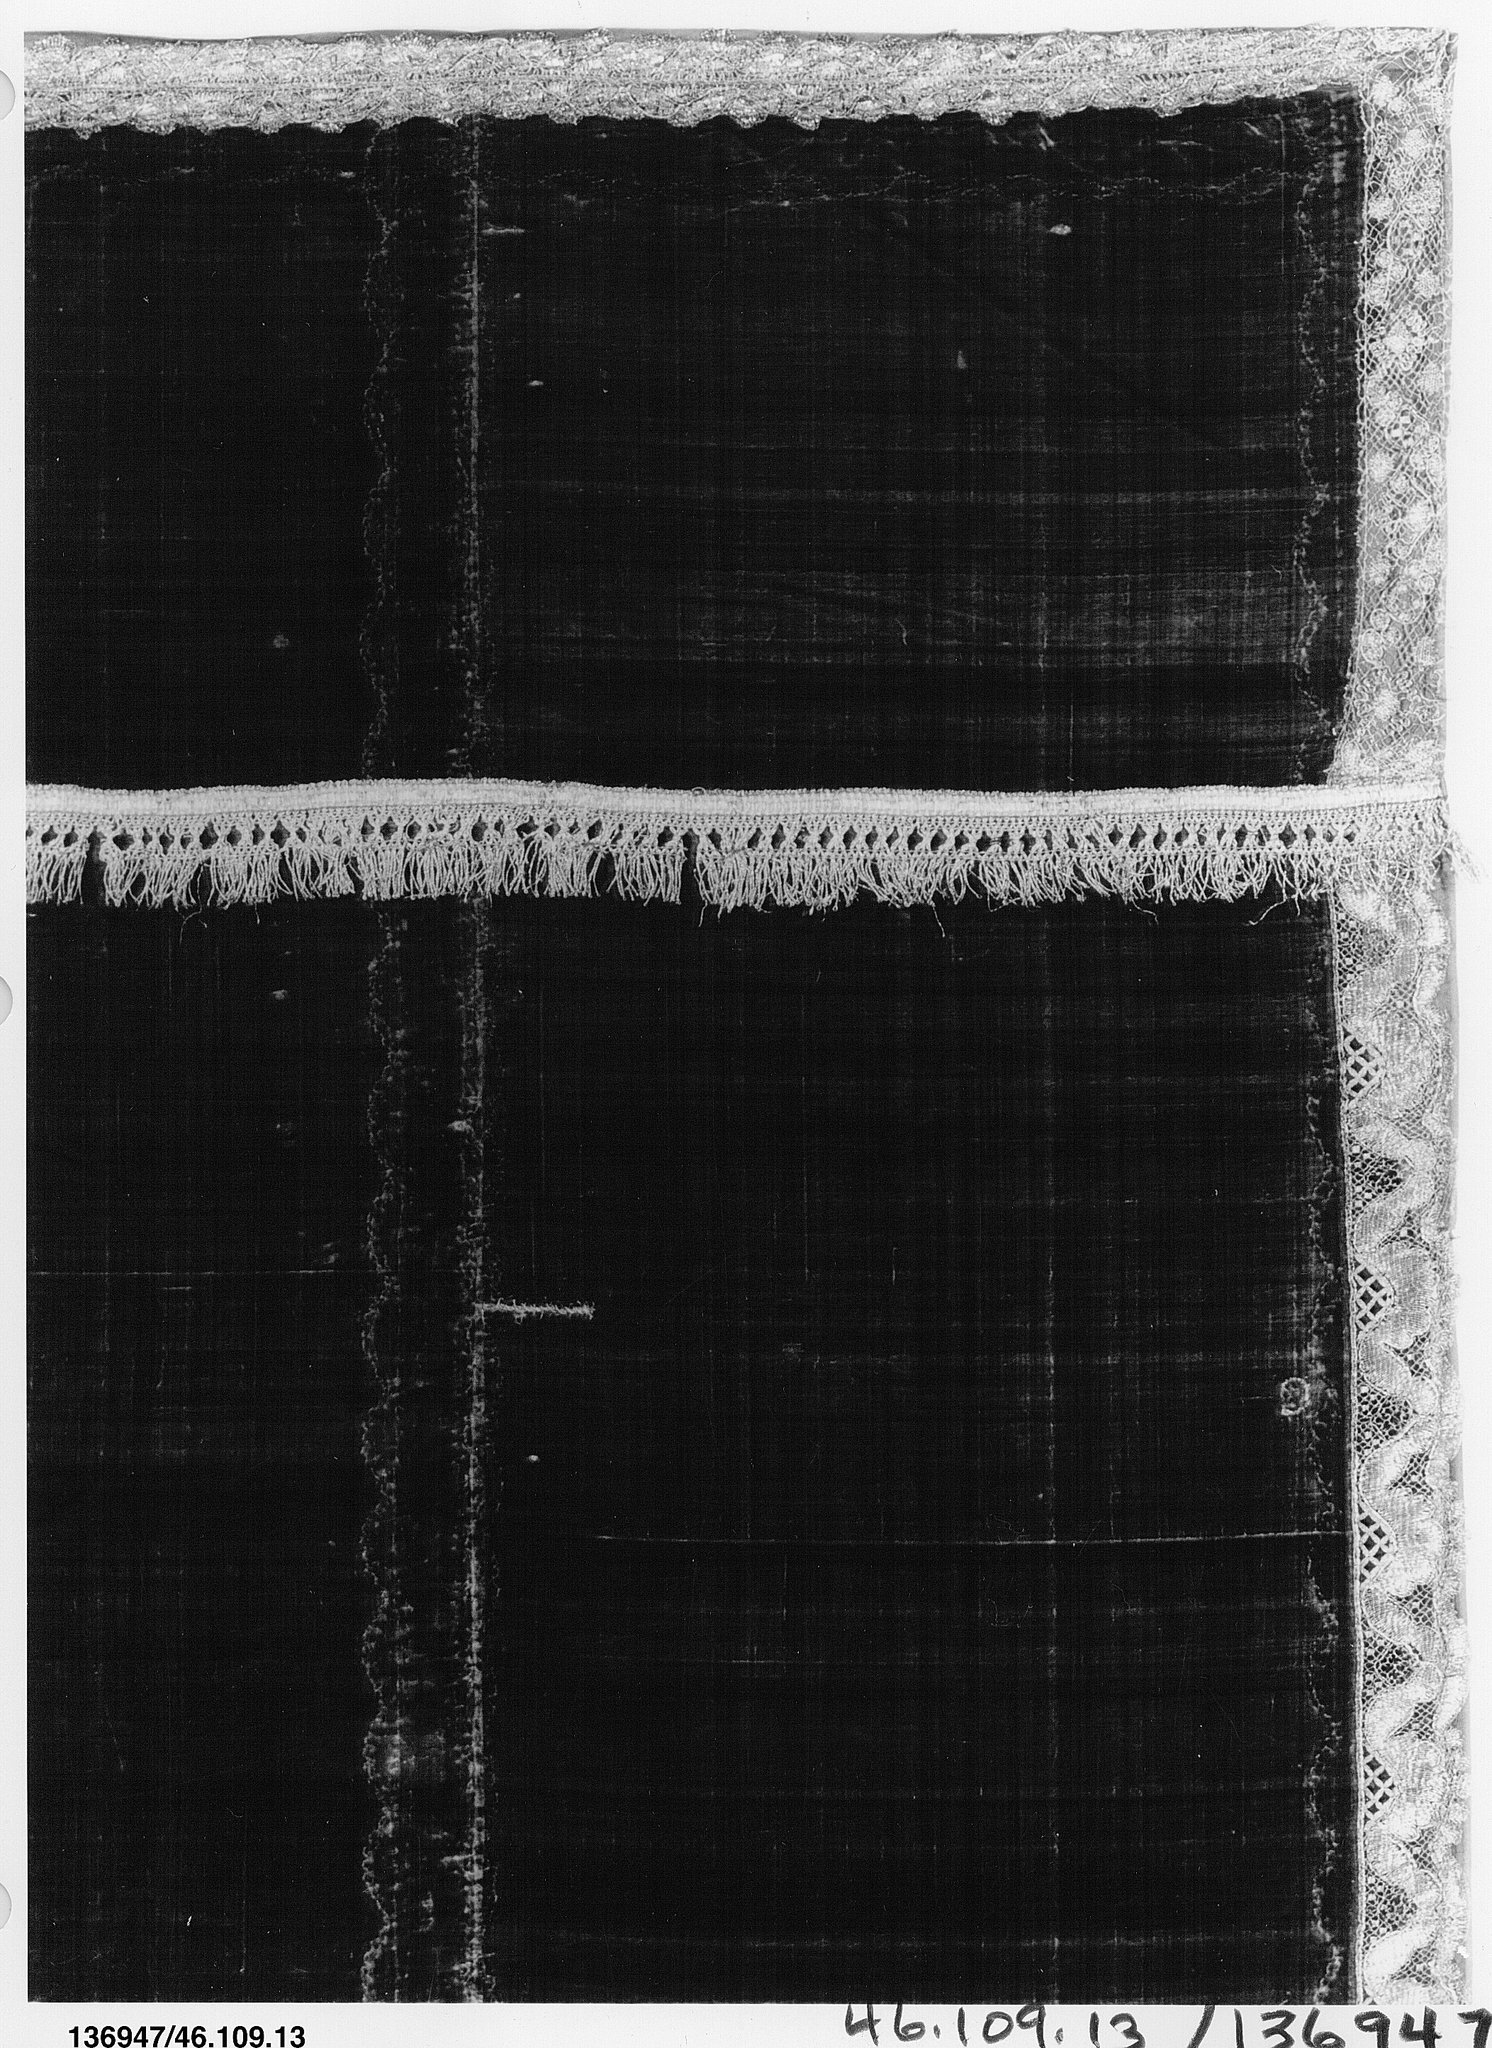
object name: piece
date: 1601-1700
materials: silk